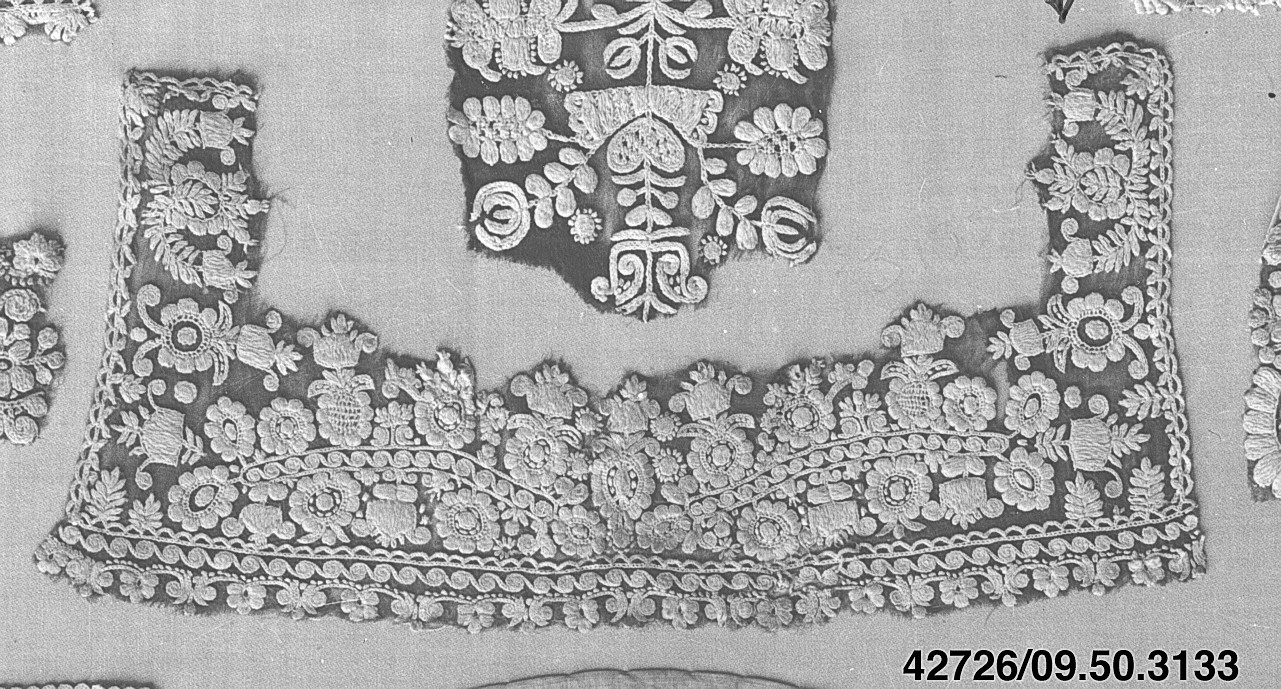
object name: fragment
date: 1801-1900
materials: silk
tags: flowers,leaves